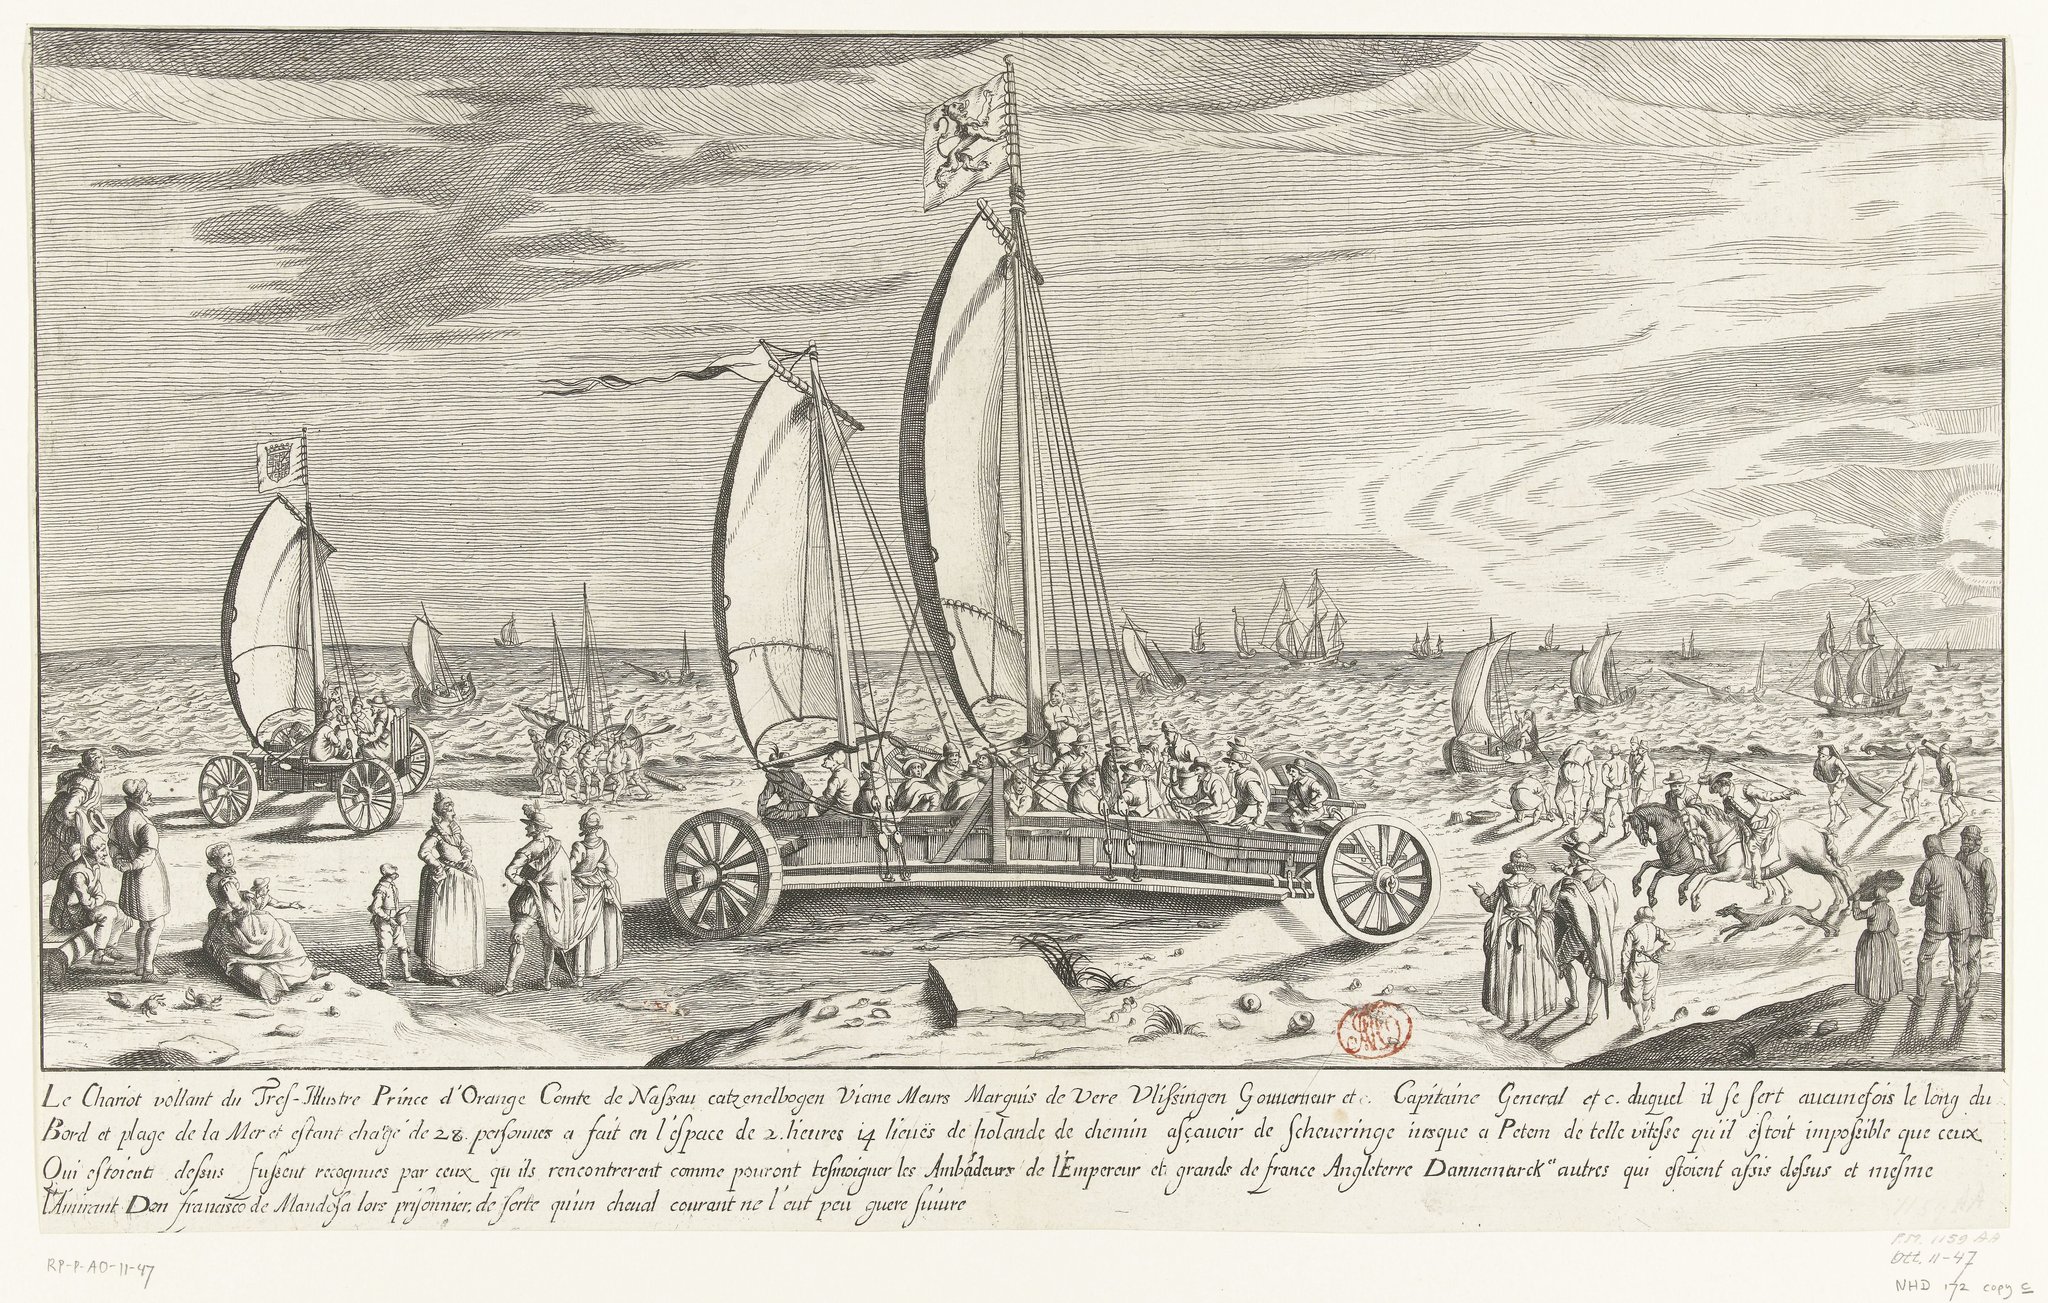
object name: print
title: De zeilwagen van Simon Stevin, 1602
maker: Anonymous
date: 1603-1699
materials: paper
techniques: engraving, etching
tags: maurice (prince of orange), simon stevin, sailing-car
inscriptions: collector's mark: Lugt 195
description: De zeilwagen van Simon Stevin, 1602. Prins Maurits maakt samen met een groep vrienden een tocht over het strand van Scheveningen naar Petten in de zeilwagen gebouwd door Simon Stevin, april-mei 1602. Links een kleine zeilwagen, waarschijnlijk een prototype, met enkele personen aan boord. Op het strand verschillende elegante toeschouwers en enkele vissers. Met onderschrift van 4 regels in het Frans.